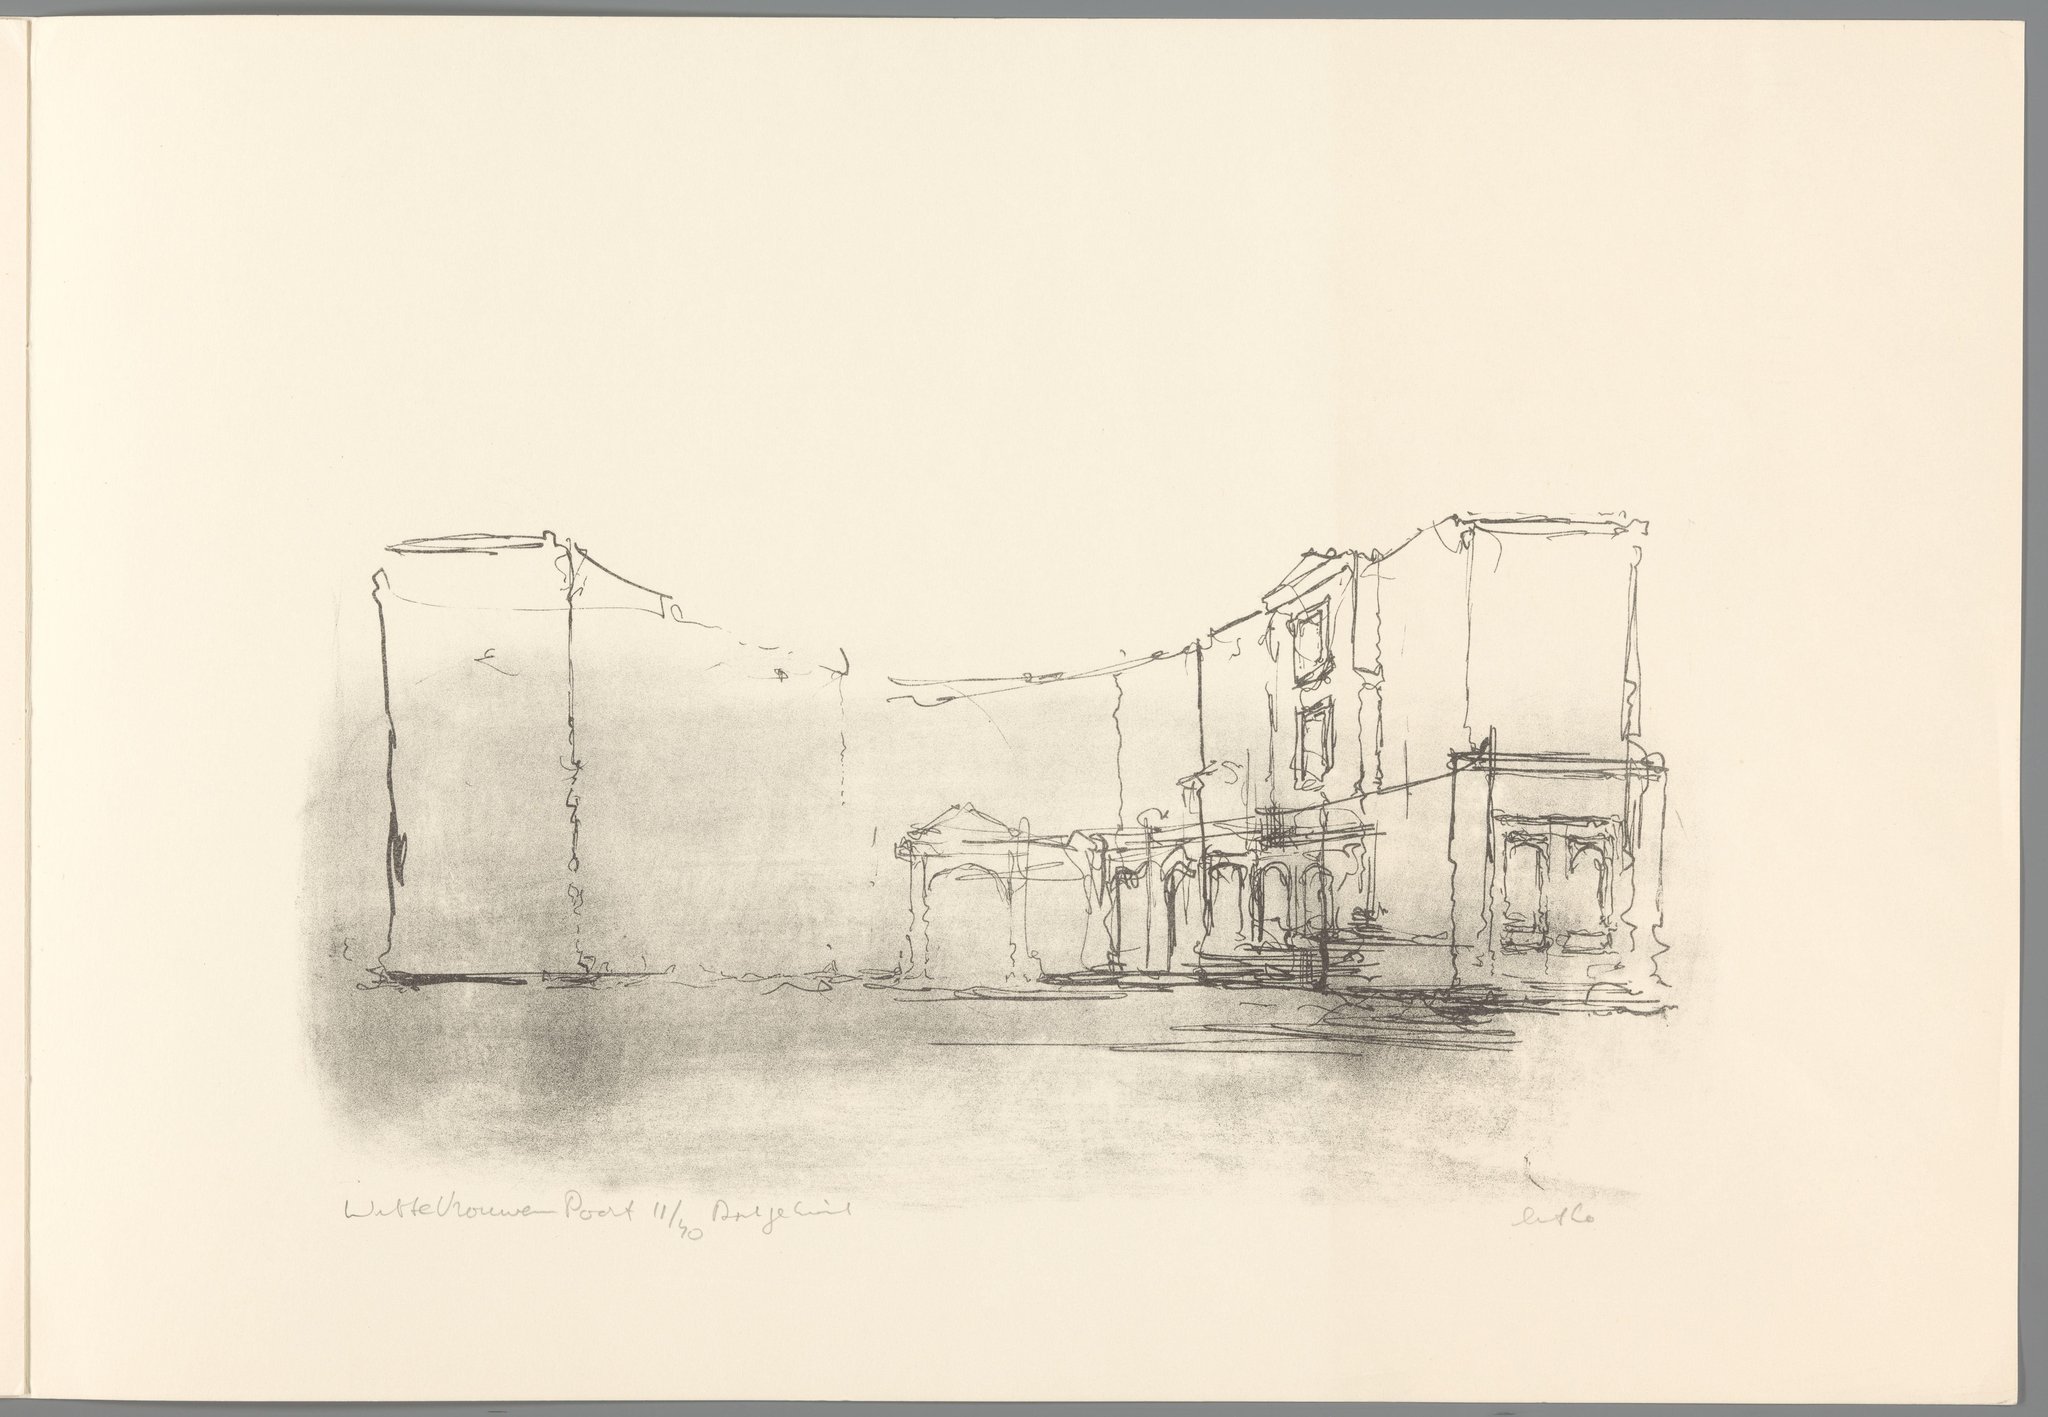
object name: print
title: Wittevrouwenpoort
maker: dirkje kuik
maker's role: print maker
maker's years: 1929-2008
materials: paper, ink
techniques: lithograph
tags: wittevrouwenpoort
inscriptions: inscription: ‘litho’, signature, date and inscription: ‘Wittevrouwen Poort 11/49 Dirkje Kuik’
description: Het tweede (gevouwen) blad met een schets van een stadspoort.